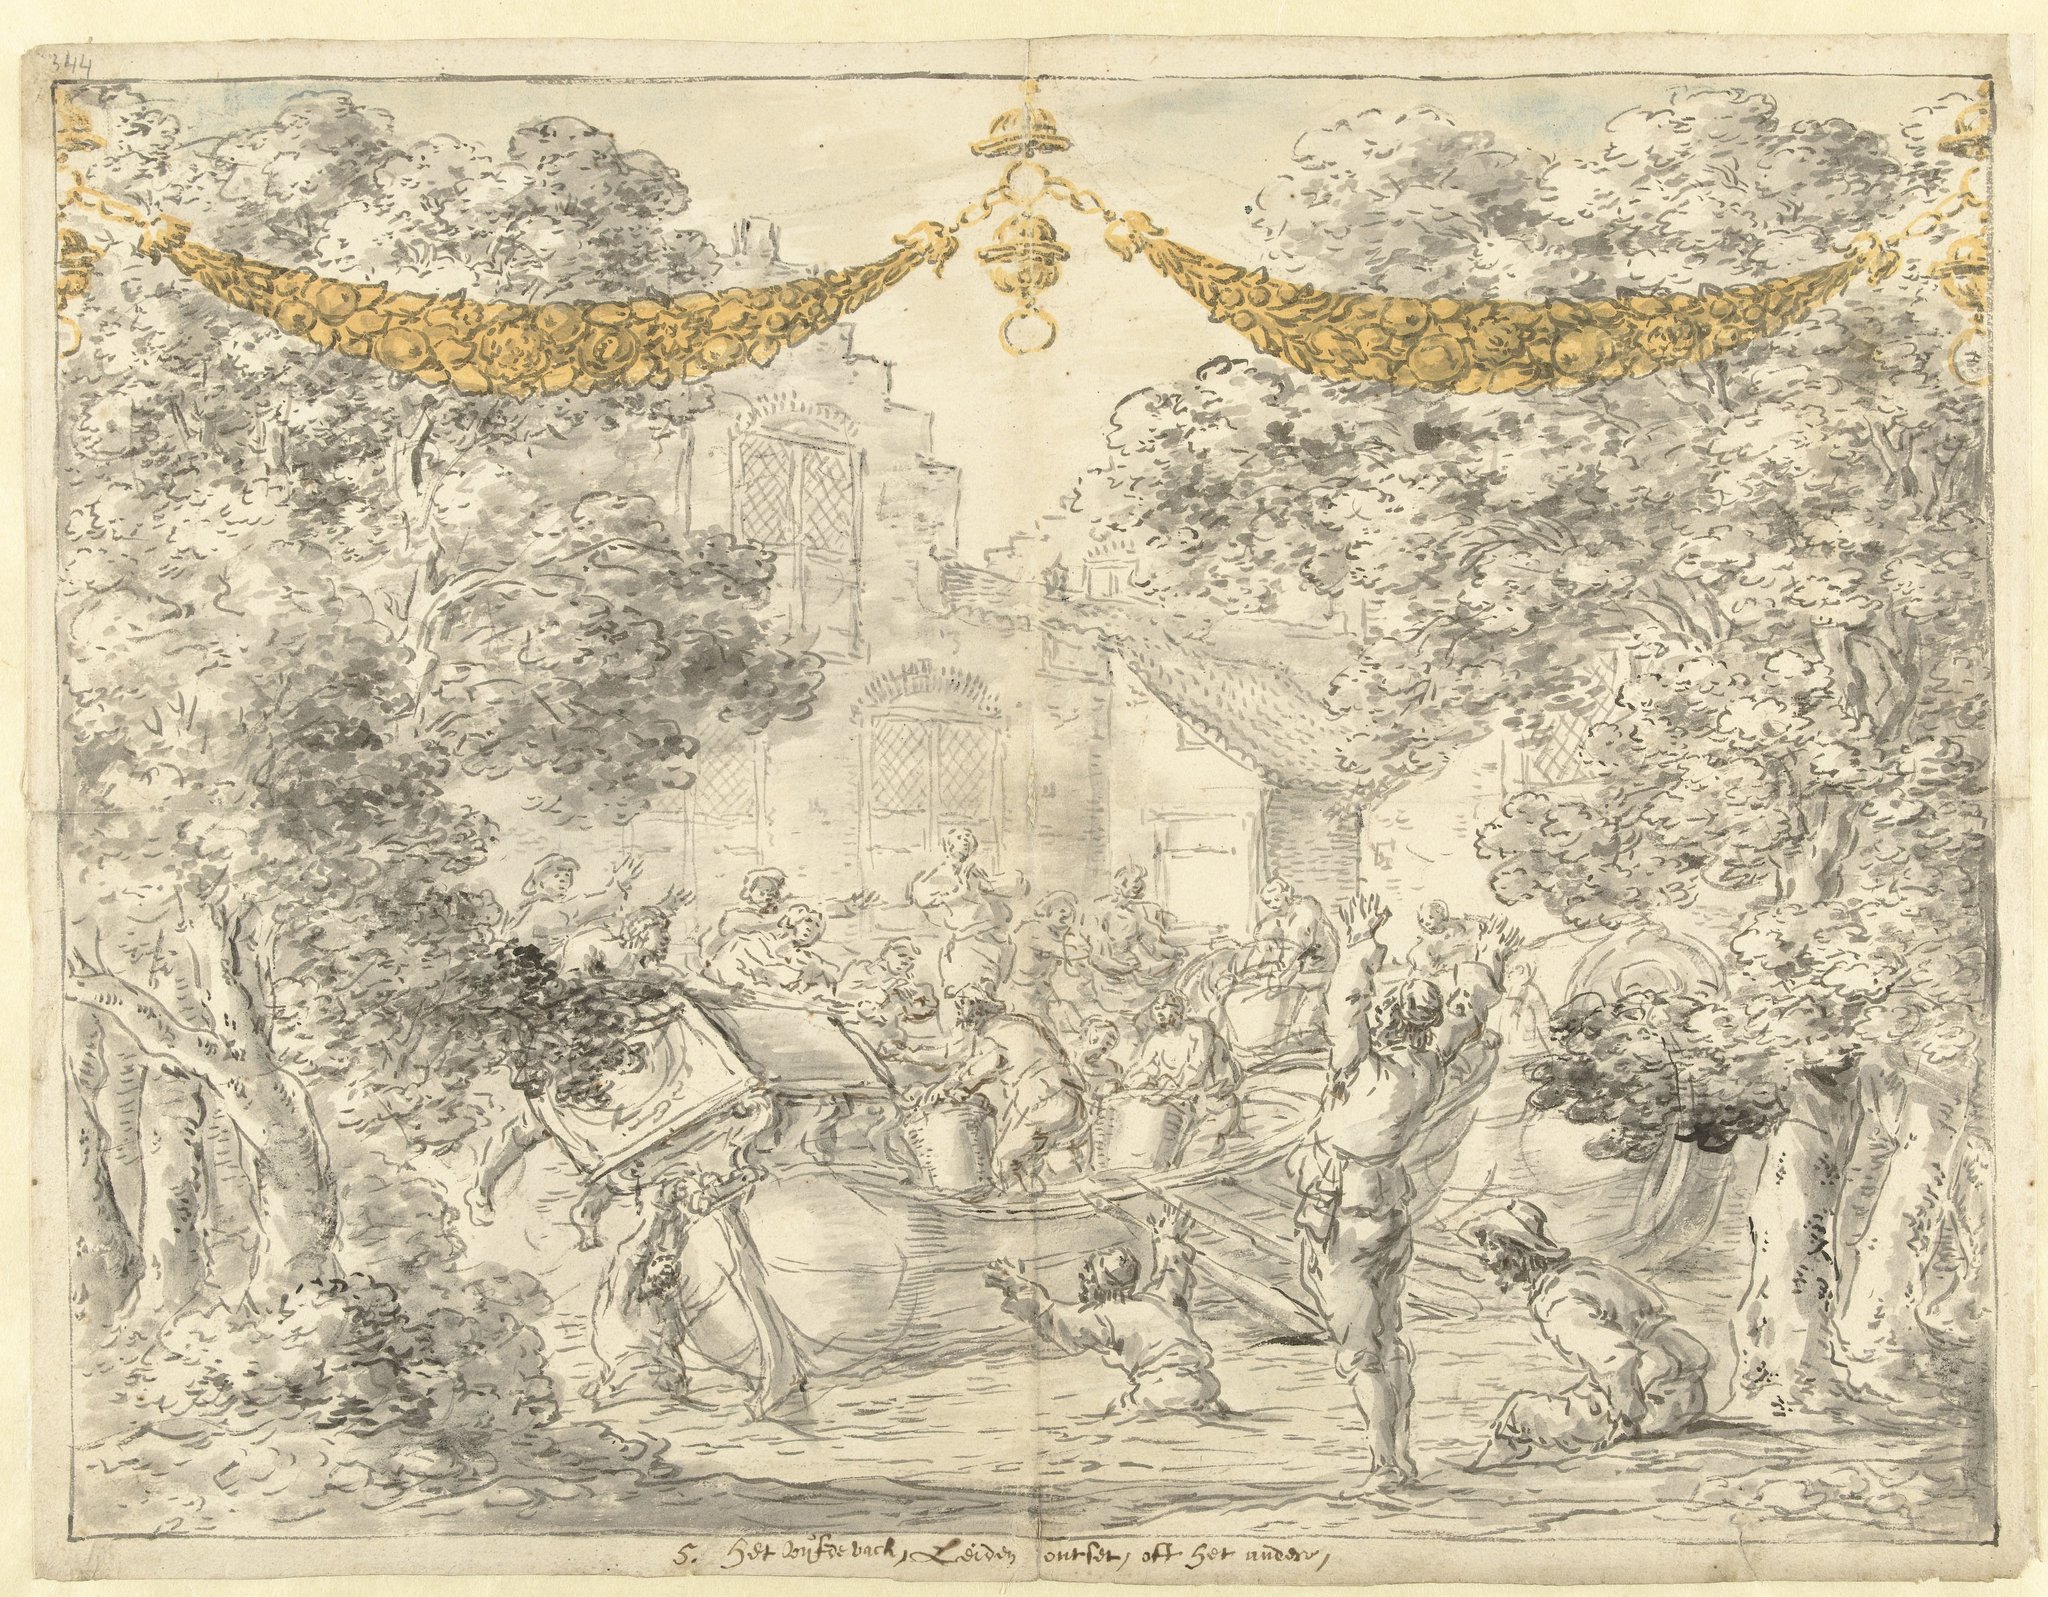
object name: historieplaat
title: Het vijfde vack / Leiden ontzet / oft het andere /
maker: leonaert bramer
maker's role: draughtsman, painter, print maker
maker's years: 1596-1674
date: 1606-1674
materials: ink, paper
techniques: brush, pen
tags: liberation of besieged city, leiden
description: Leidens ontzet, 3 oktober 1574. Uitdelen van voedsel vanuit een schuit aan de inwoners van Leiden. Op de voorgrond juichende personen, bovenaan een guirlande. Ontwerp voor een wanddecoratie.